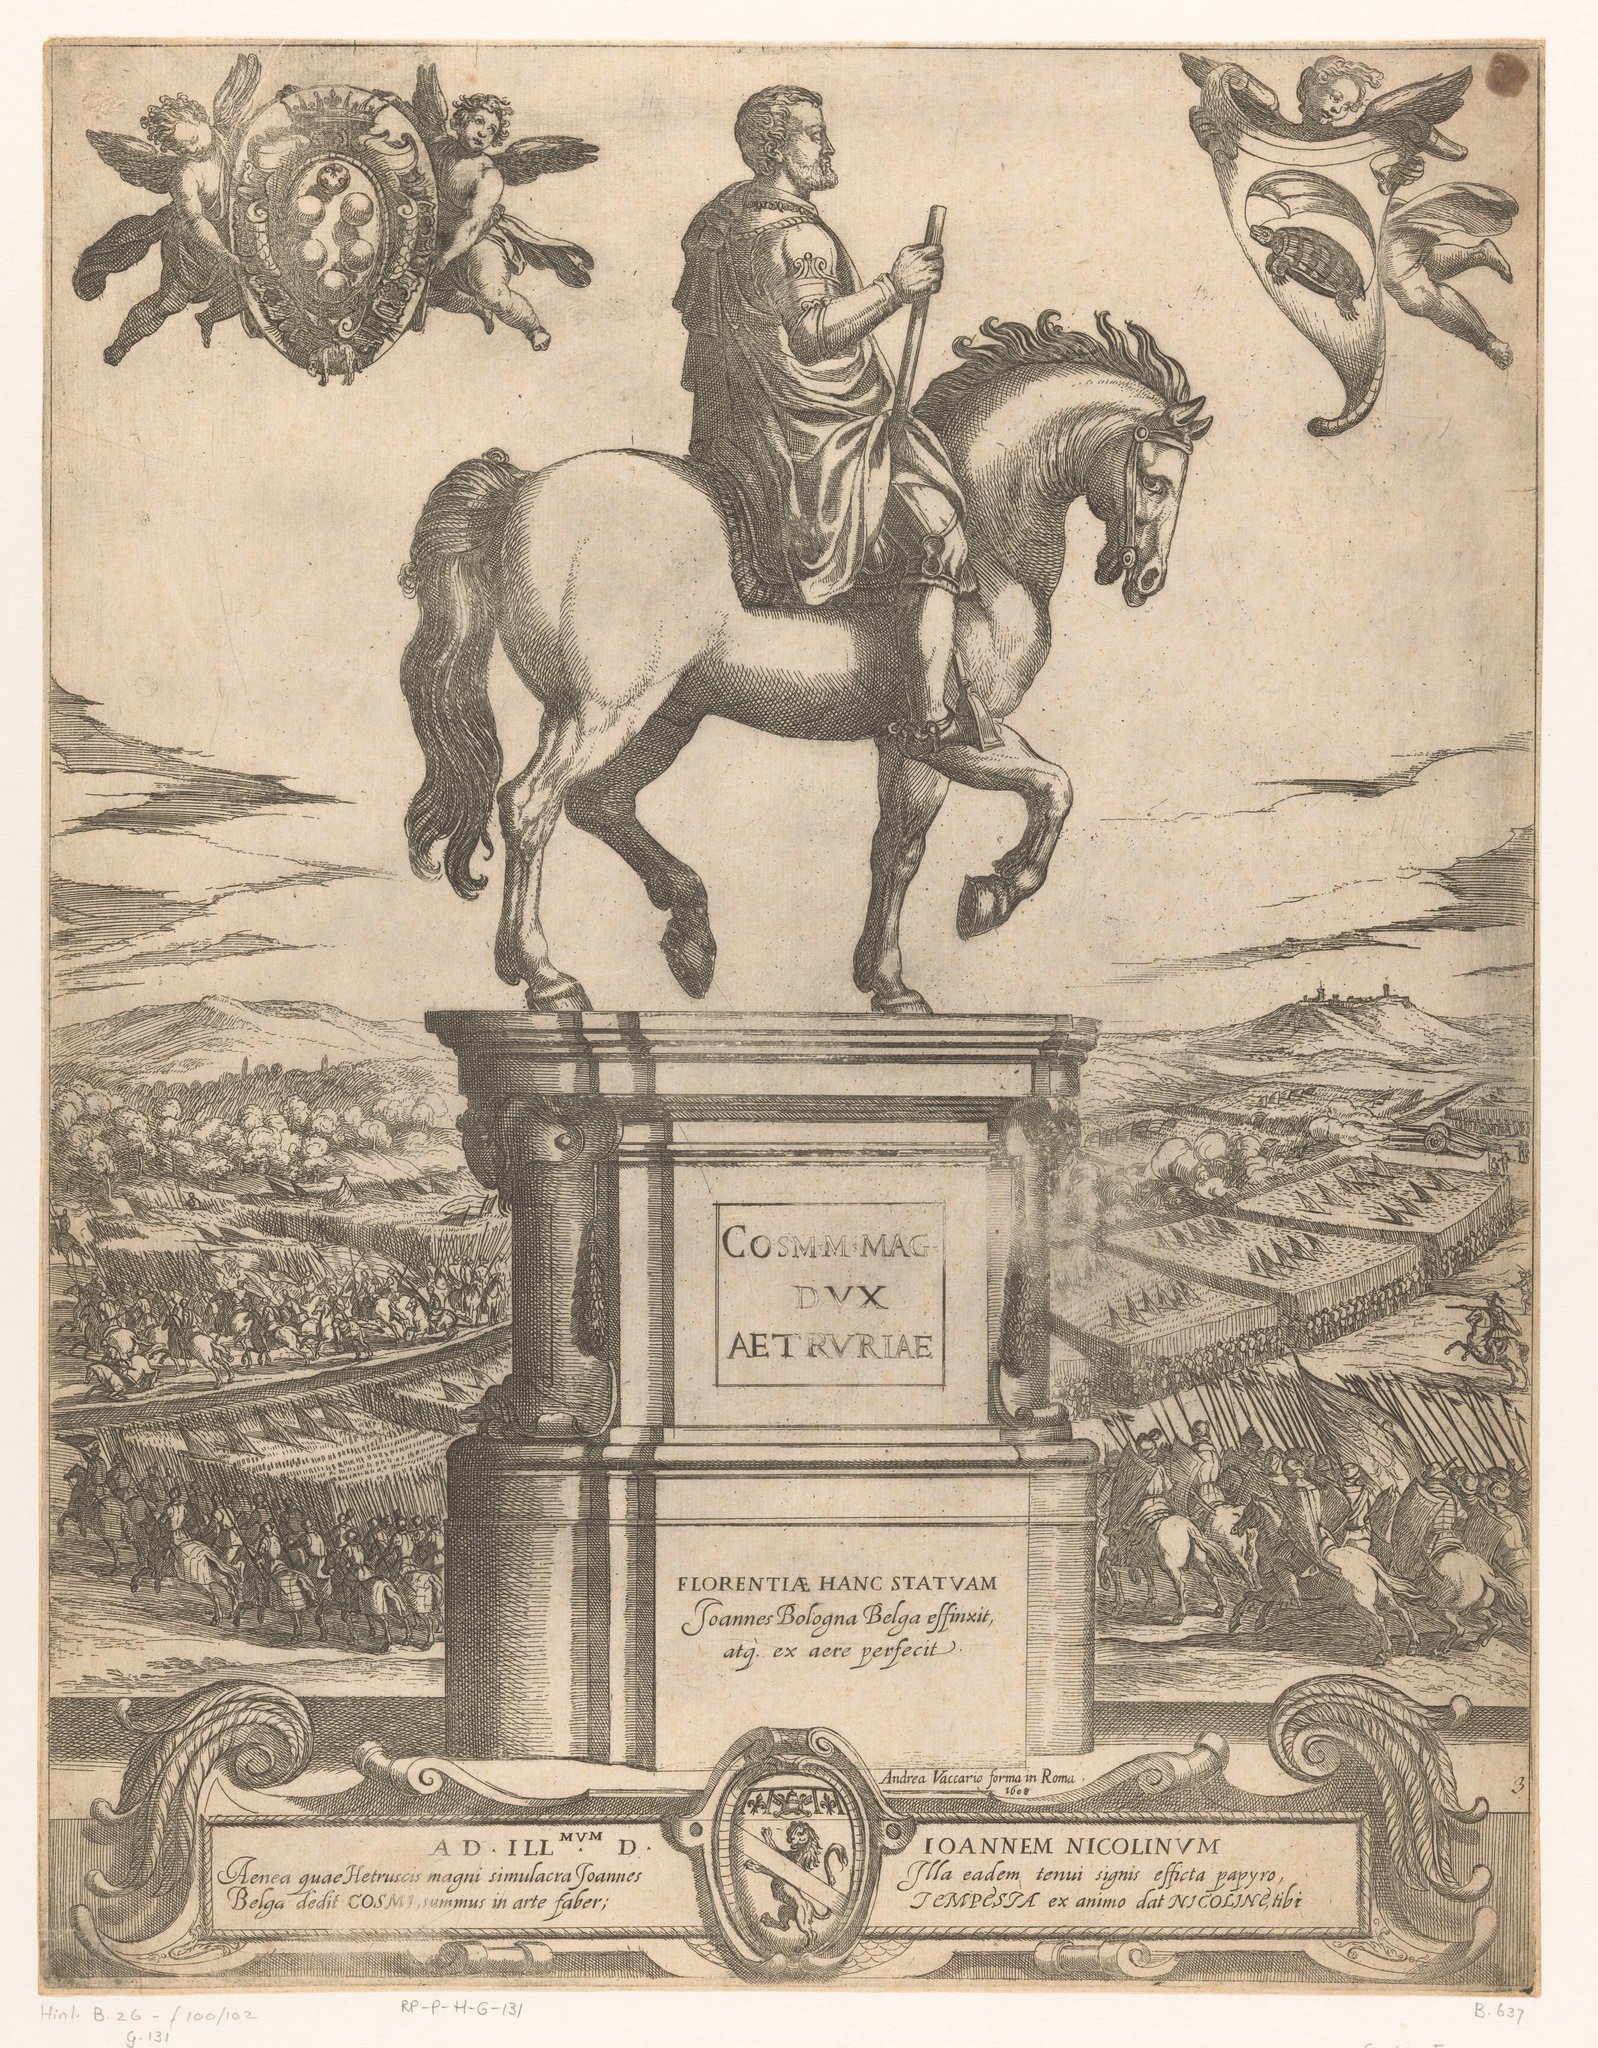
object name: print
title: Ruiterstandbeeld van Cosimo I, groothertog van Toscane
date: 1608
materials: paper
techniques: etching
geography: rome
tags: cosimo i de' medici, battle, warfare; military affairs (+ cavalry, horsemen), equestrian statue, the soldier; the soldier's life, cupids: 'amores', 'amoretti', 'putti'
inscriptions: number: ‘3’, collector's mark: Lugt 11, collector's mark: ‘Hinloopen’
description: Ruiterstandbeeld van Cosimo I, groothertog van Toscane. Op de achtergrond strijdende soldaten. Linksboven het wapen van de familie De'Medici gedragen door putti en rechtsboven een engel met een cartouche met het embleem van Cosimo. Onder het standbeeld een cartouche met opdracht in het Latijn.